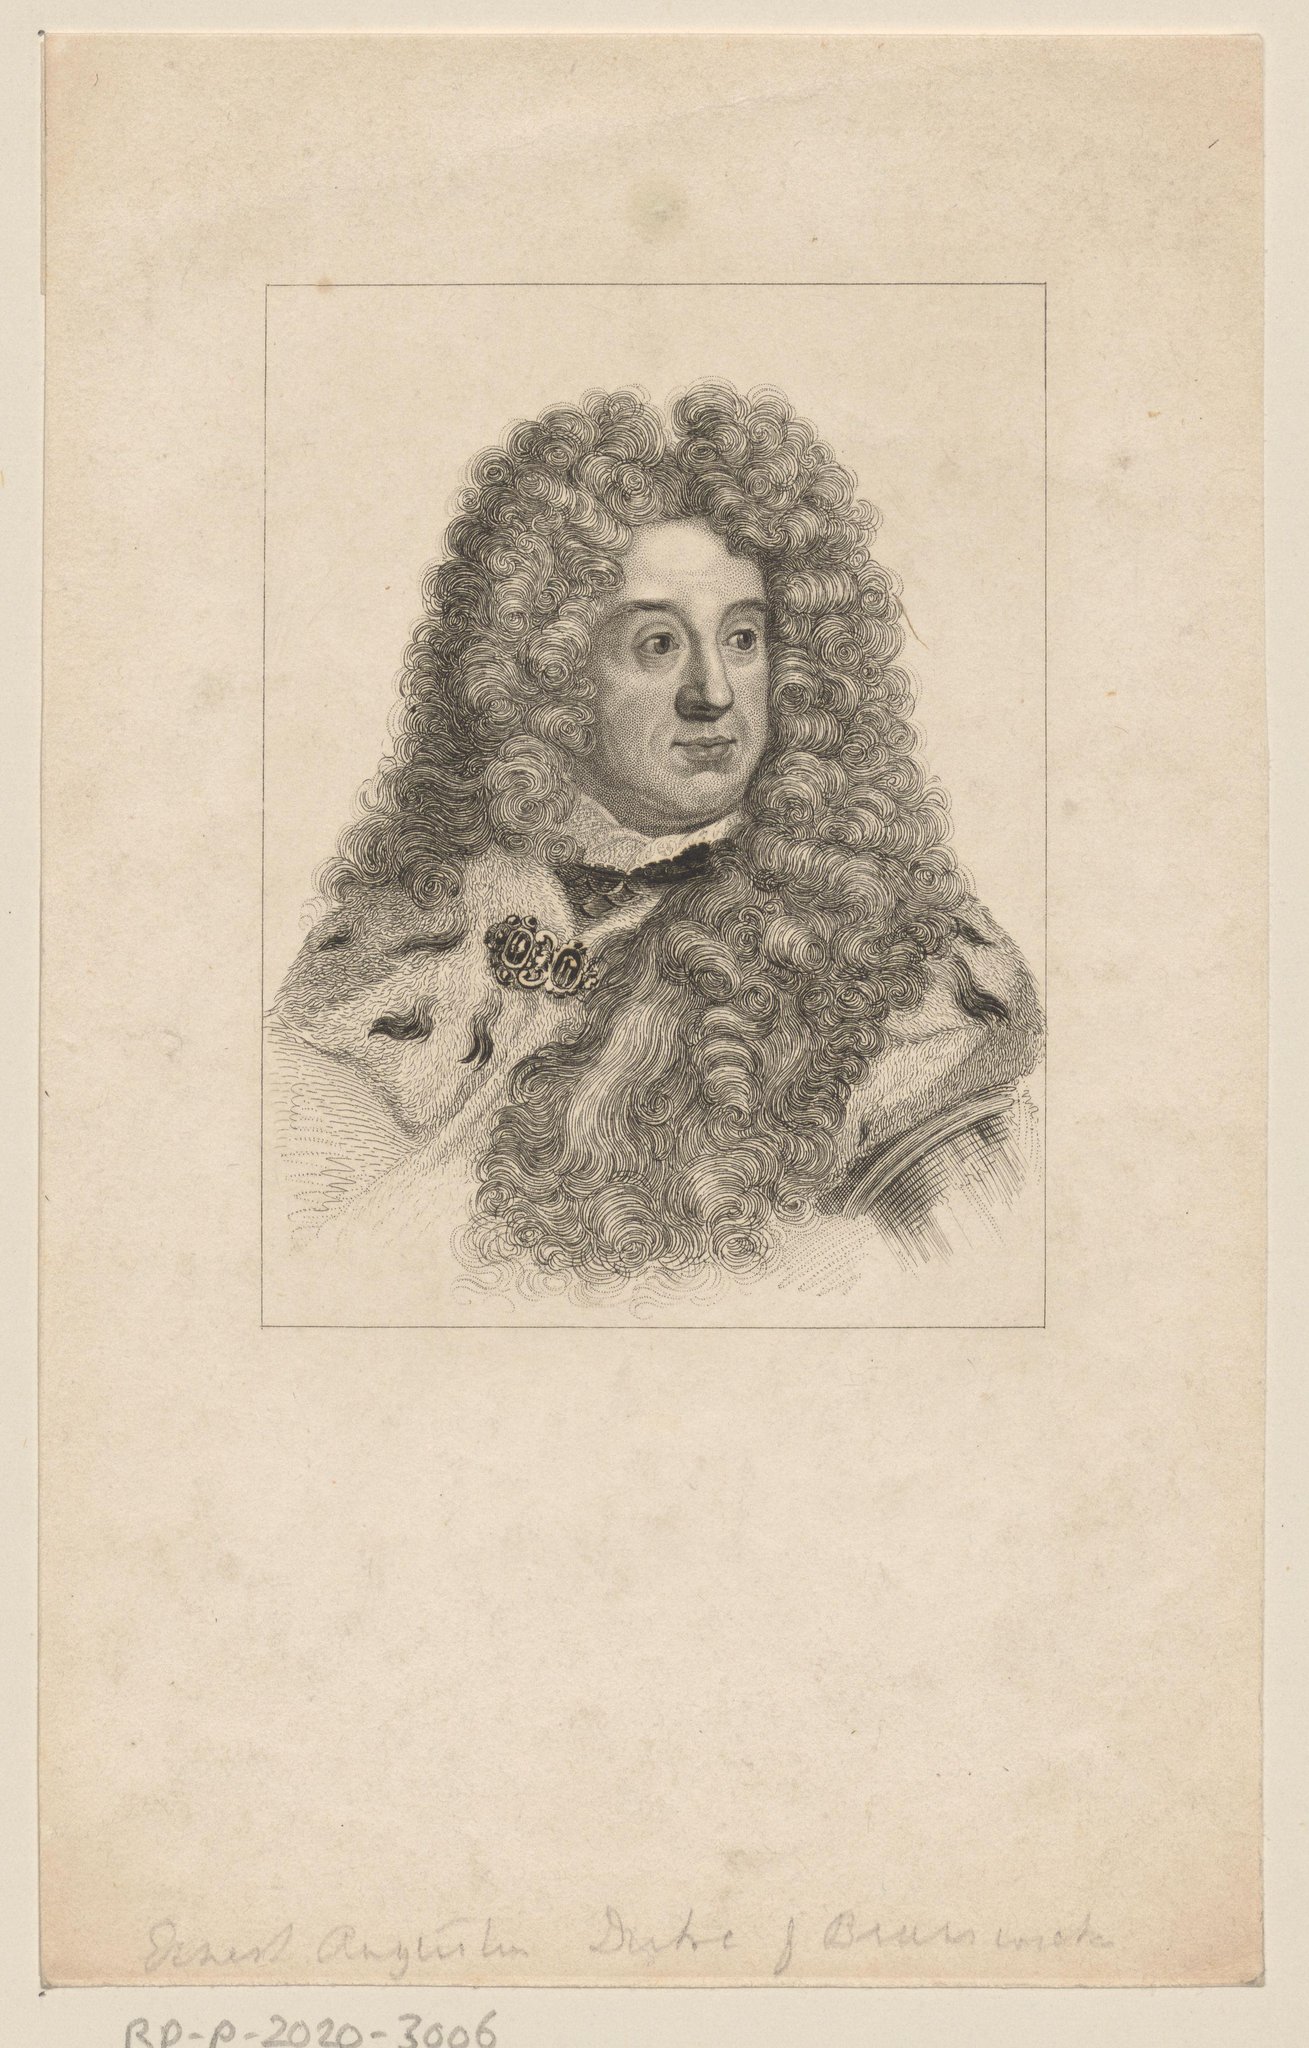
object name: print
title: Portret van Ernst August van Brunswijk-Lüneburg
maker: Anonymous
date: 1750-1800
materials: paper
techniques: engraving, etching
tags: historical persons